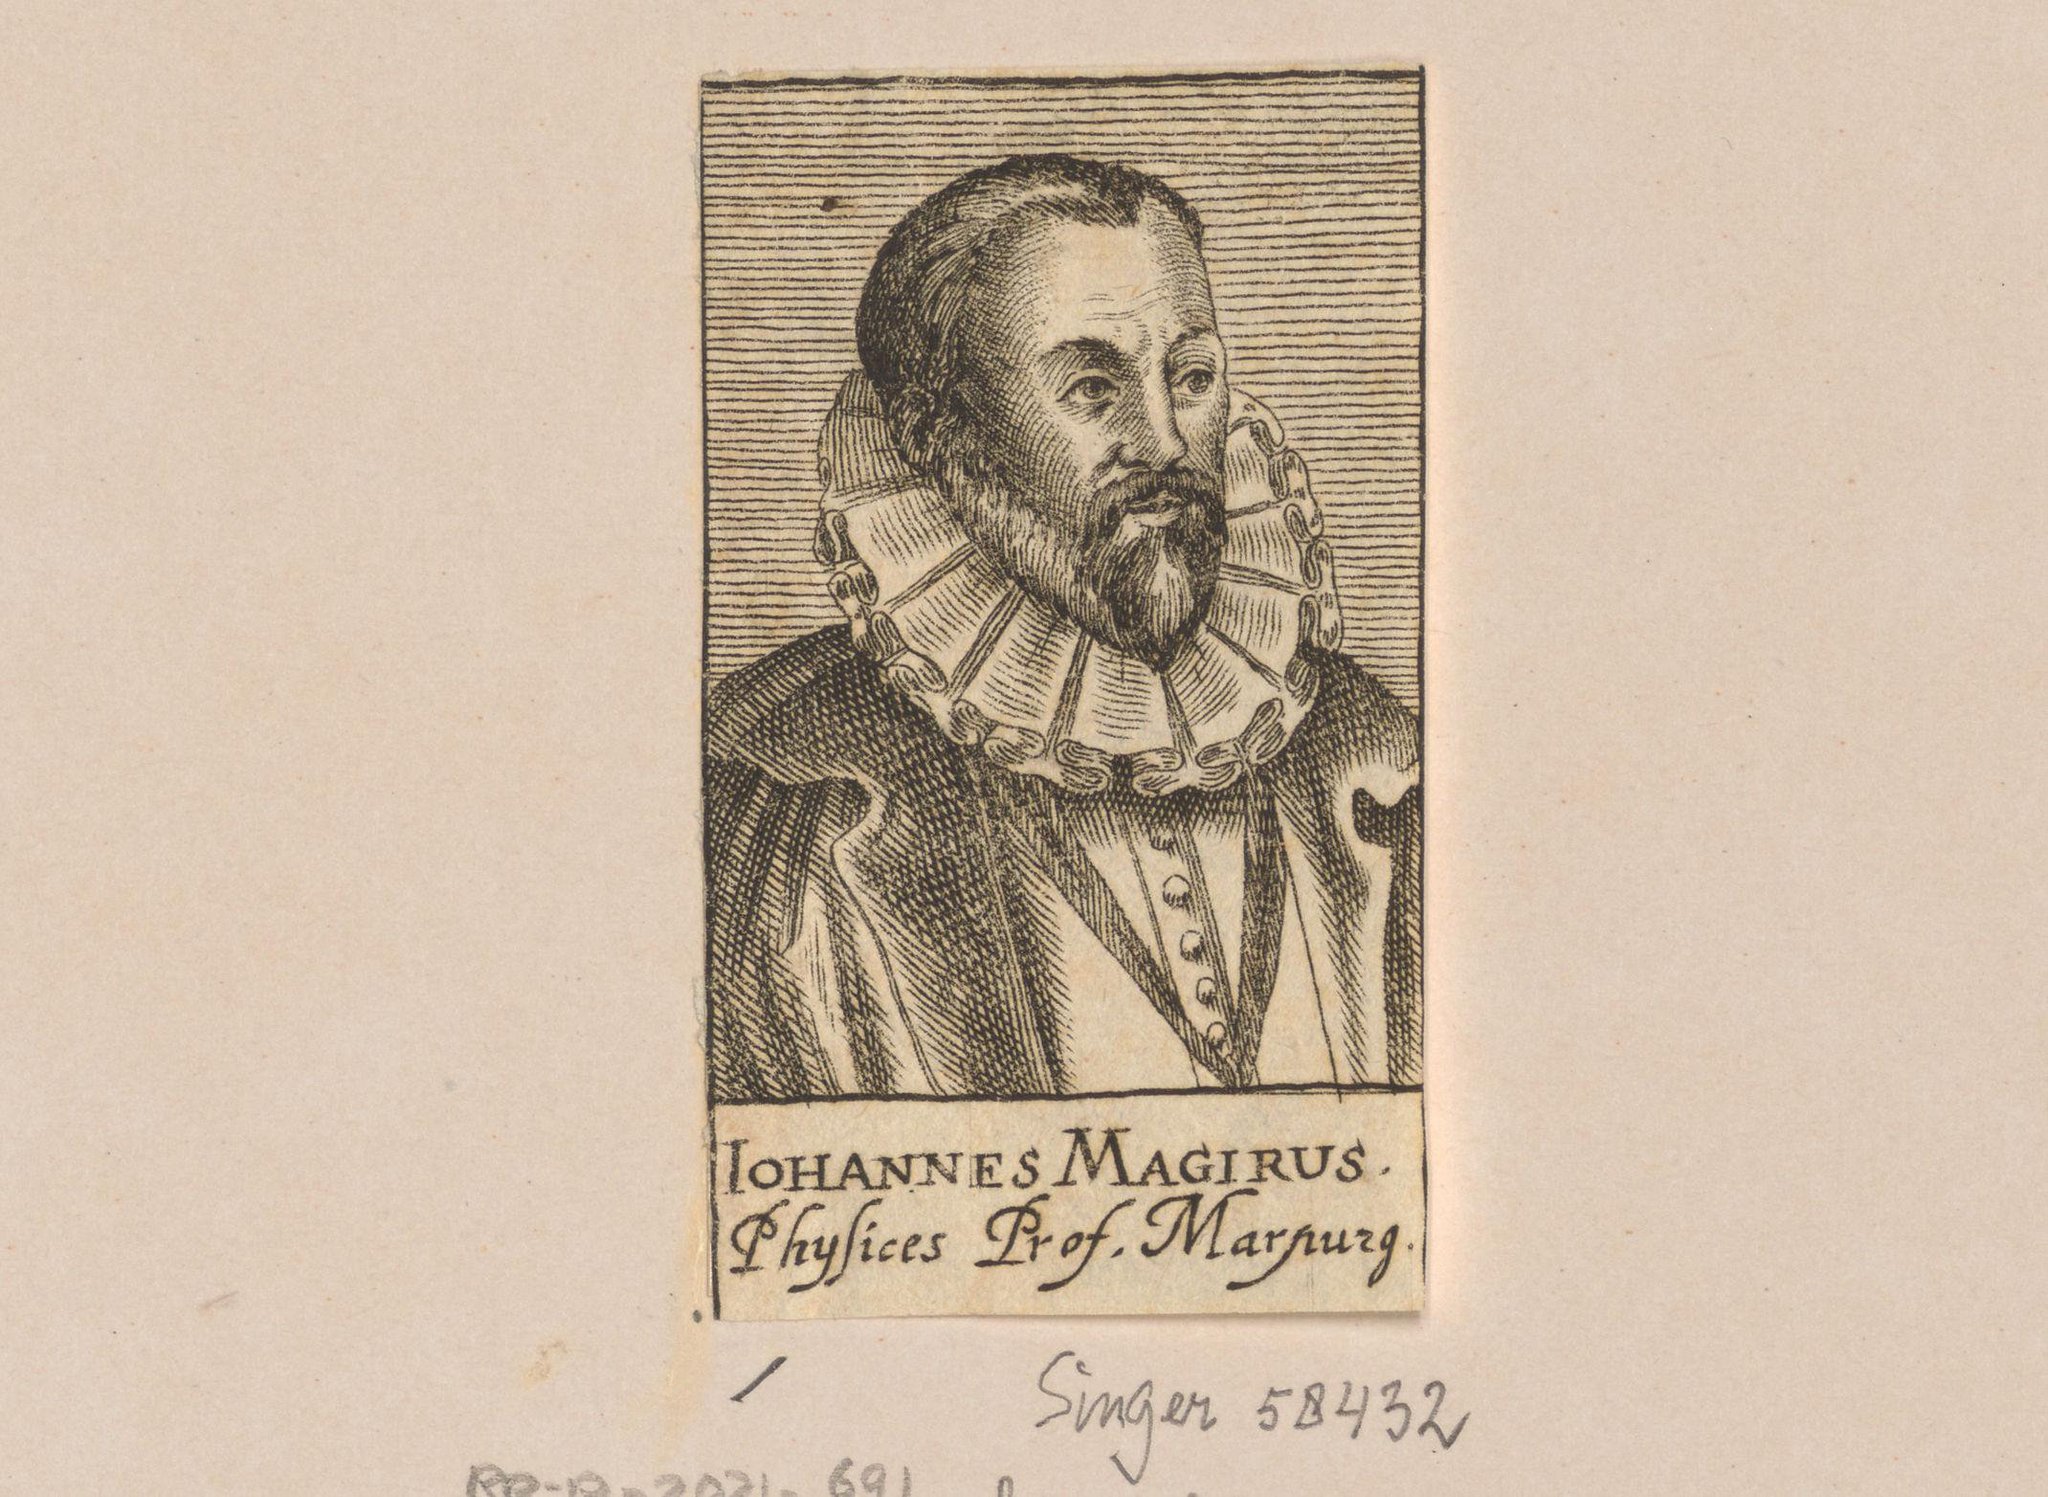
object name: print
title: Portret van Johannes Magirus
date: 1688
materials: paper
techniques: engraving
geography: nuremberg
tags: historical persons, scholar, philosopher (+ portrait of scholar, scientist)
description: Prent uit: Freher, Paul. Theatrum virorum eruditione clarorum. Neurenberg: Johann Hoffmann, 1688.